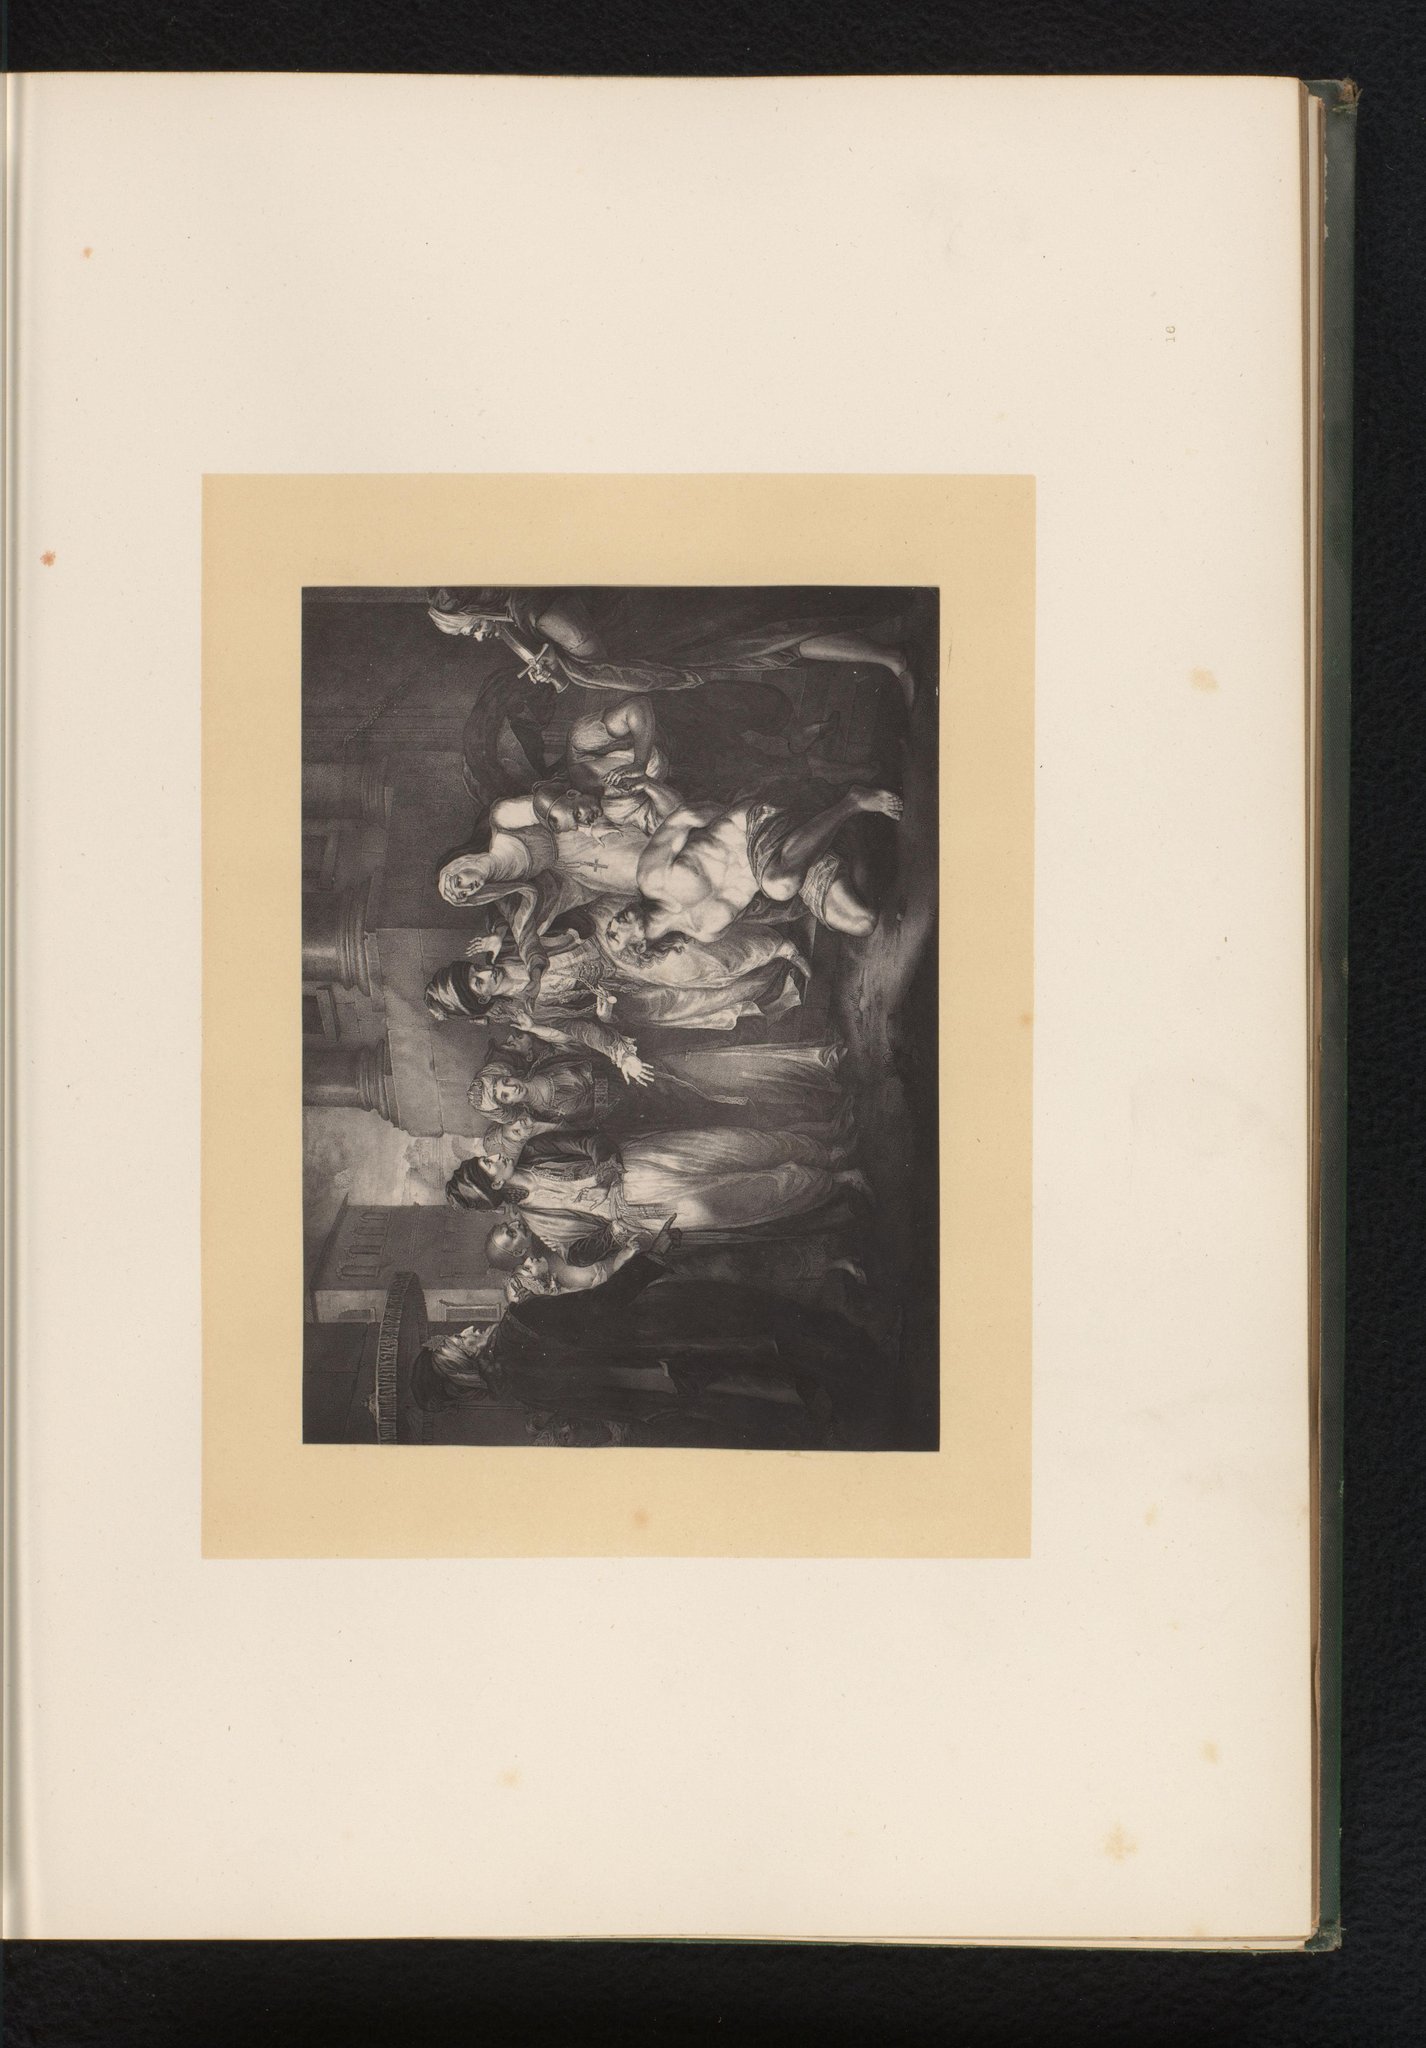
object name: photomechanical print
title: The Comedy of Errors, Act V, Scene 1: A Street before the Priory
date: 1874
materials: paper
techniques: woodburytype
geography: london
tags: comedy